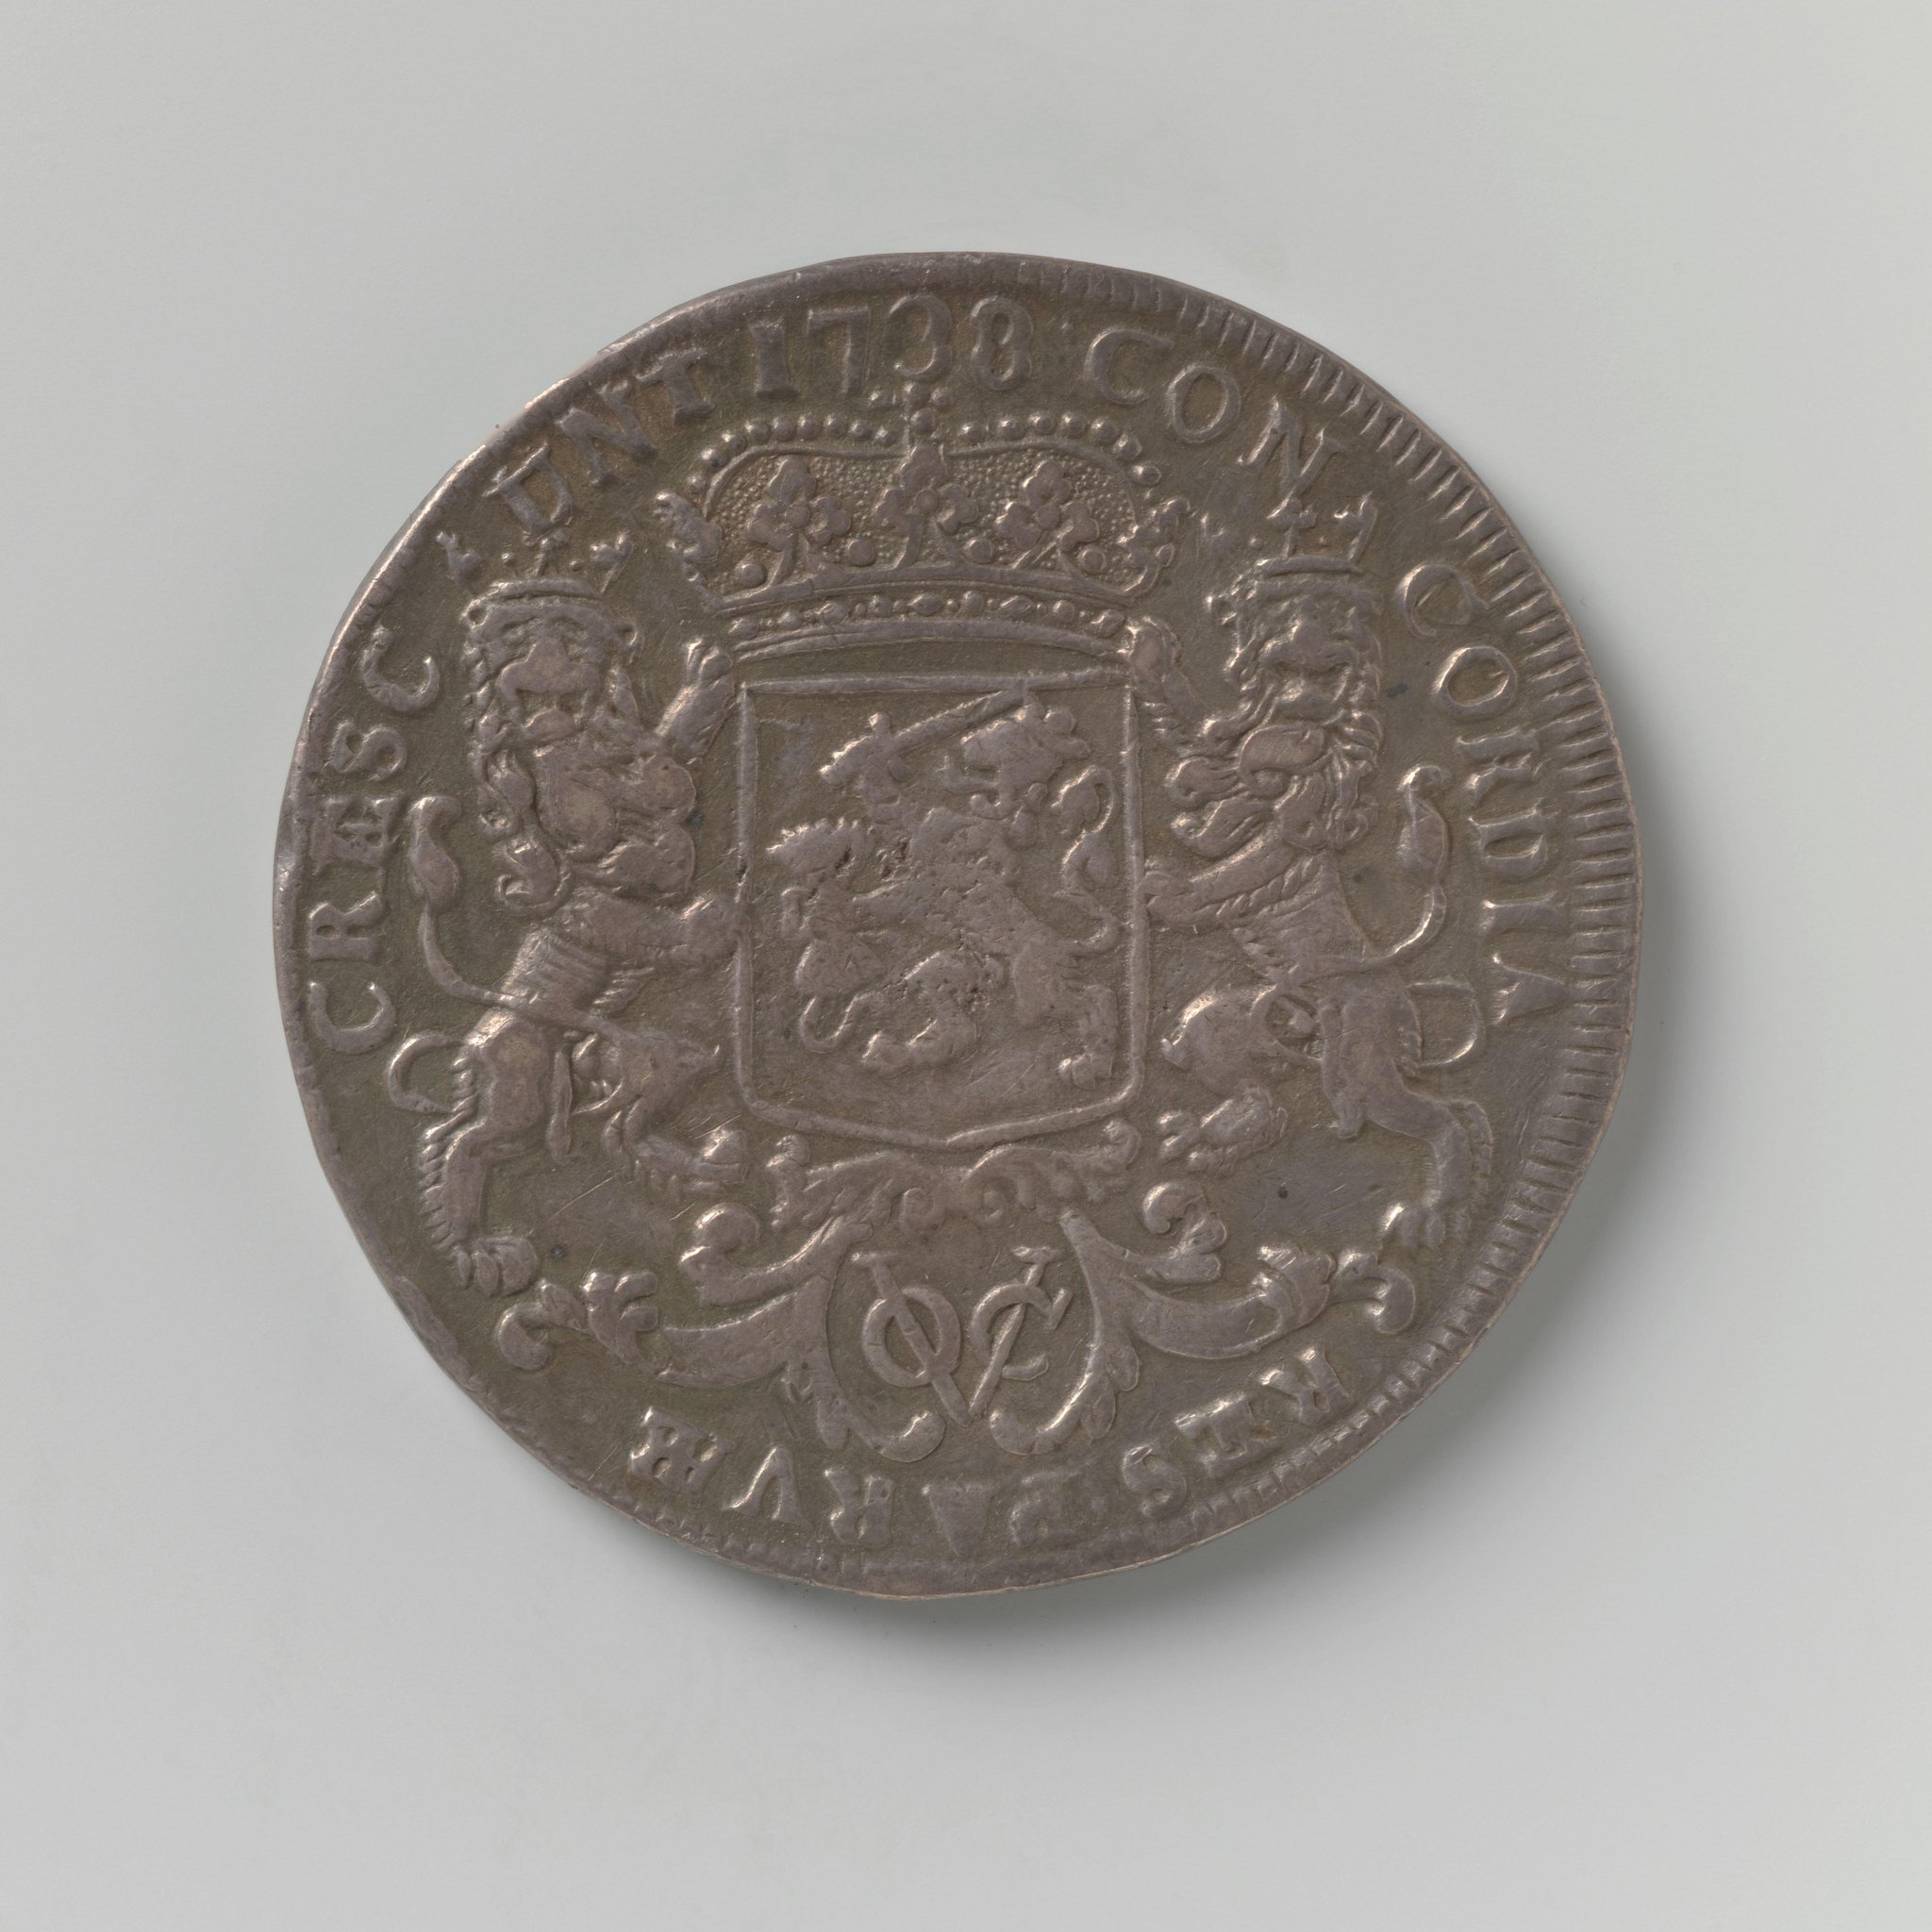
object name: coin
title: VOC, zilveren rijder, Zeeland, 1738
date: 1738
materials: silver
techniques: striking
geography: middelburg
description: Zilveren munt. Voorzijde: geharnaste ridder met zwaard te paard naar rechts, waaronder gekroond wapenschild van Zeeland. Keerzijde: gekroond generaliteitswapenschild, waaronder cartouche, waarin monogram van de VOC. Jaartal in omschrift, boven kroon. Gladde rand.